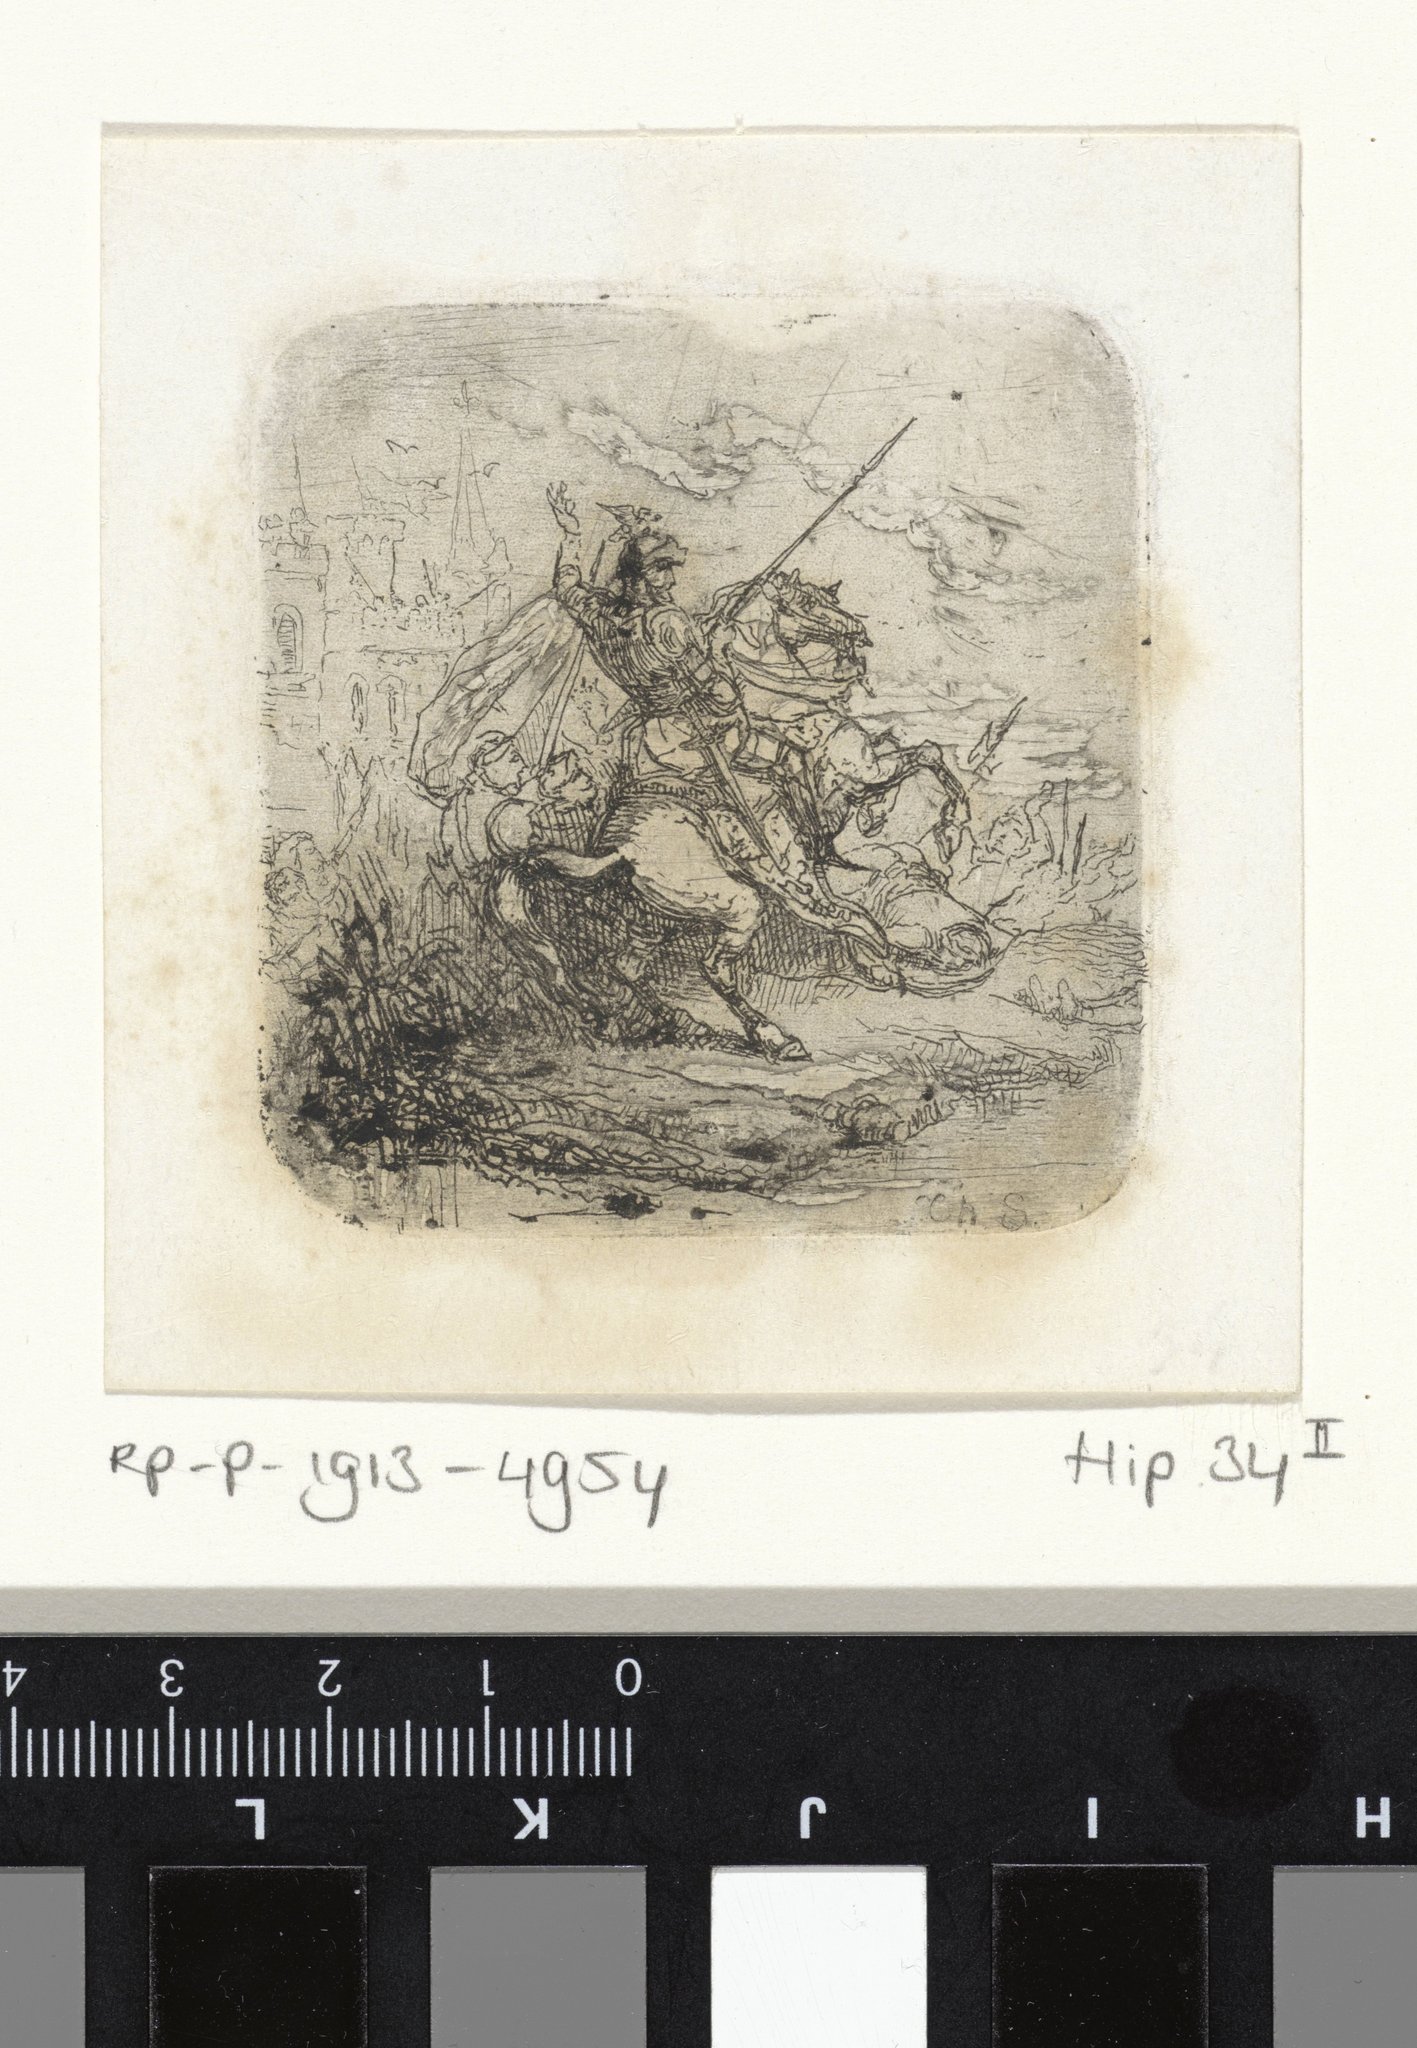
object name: print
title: Ruitergevecht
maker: theodoor schaepkens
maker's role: draughtsman, print maker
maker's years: 1810-1883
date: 1825-1883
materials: paper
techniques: aquatint, etching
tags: battle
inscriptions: collector's mark: Lugt 2228, collector's mark: Lugt 1485